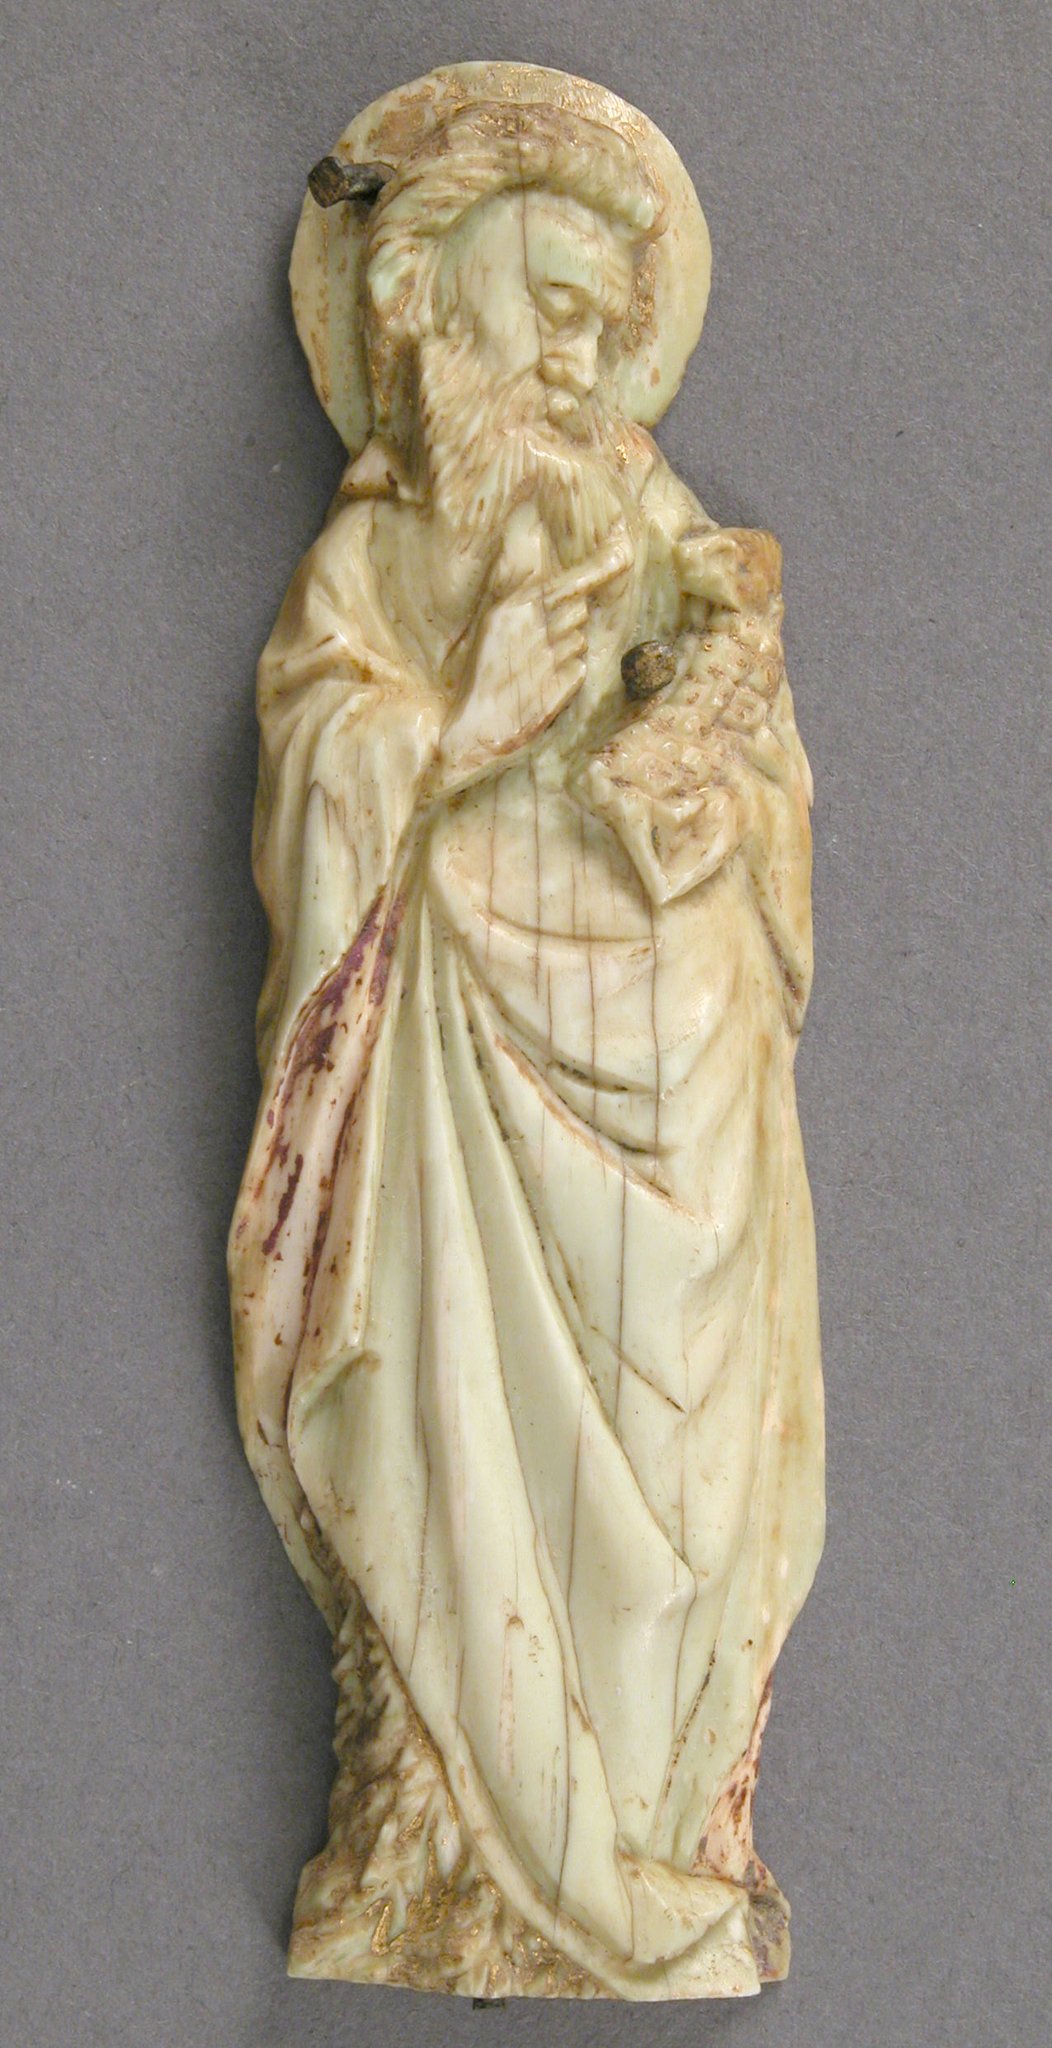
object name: plaque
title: Plaque with Saint John the Baptist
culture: french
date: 1400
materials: ivory, paint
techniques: gilding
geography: france